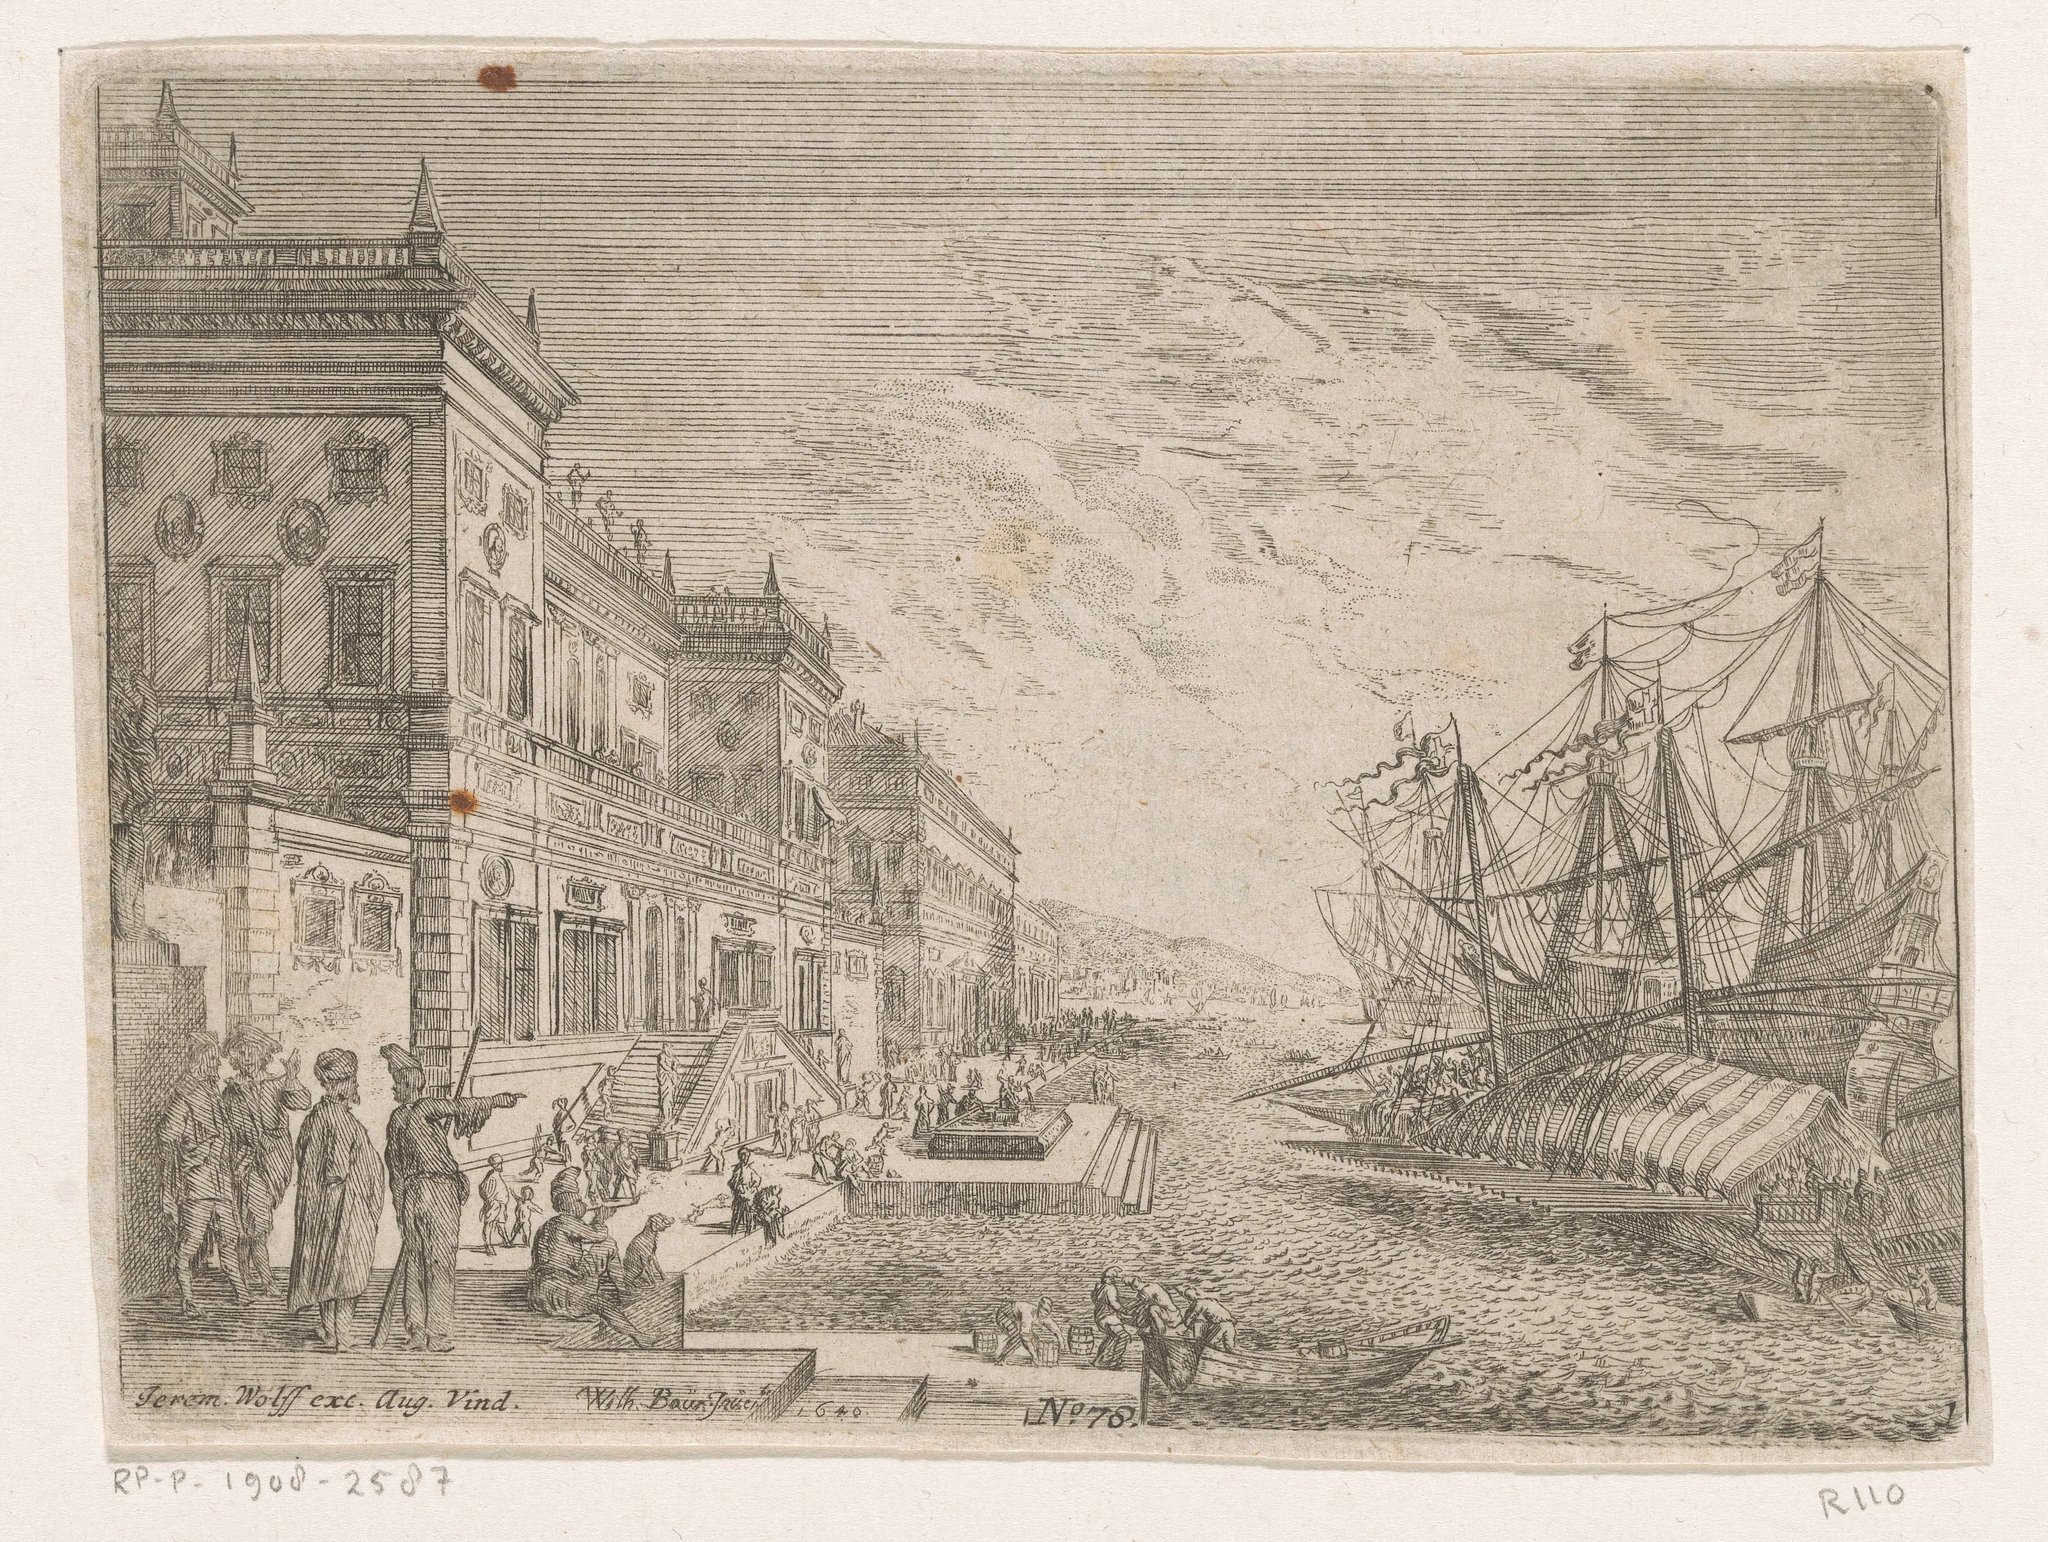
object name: print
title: Havengezicht met schepen en een galei voor een paleis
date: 1640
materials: paper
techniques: etching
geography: vienna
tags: harbour, sailing-ship, sailing-boat, palace, trireme, galley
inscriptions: collector's mark: Lugt 2228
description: Prent afkomstig uit de serie 'Havengezichten', bestaand uit zeven prenten. Het betreft hier een latere druk uitgegeven door Jeremias Wolf te Augsburg.